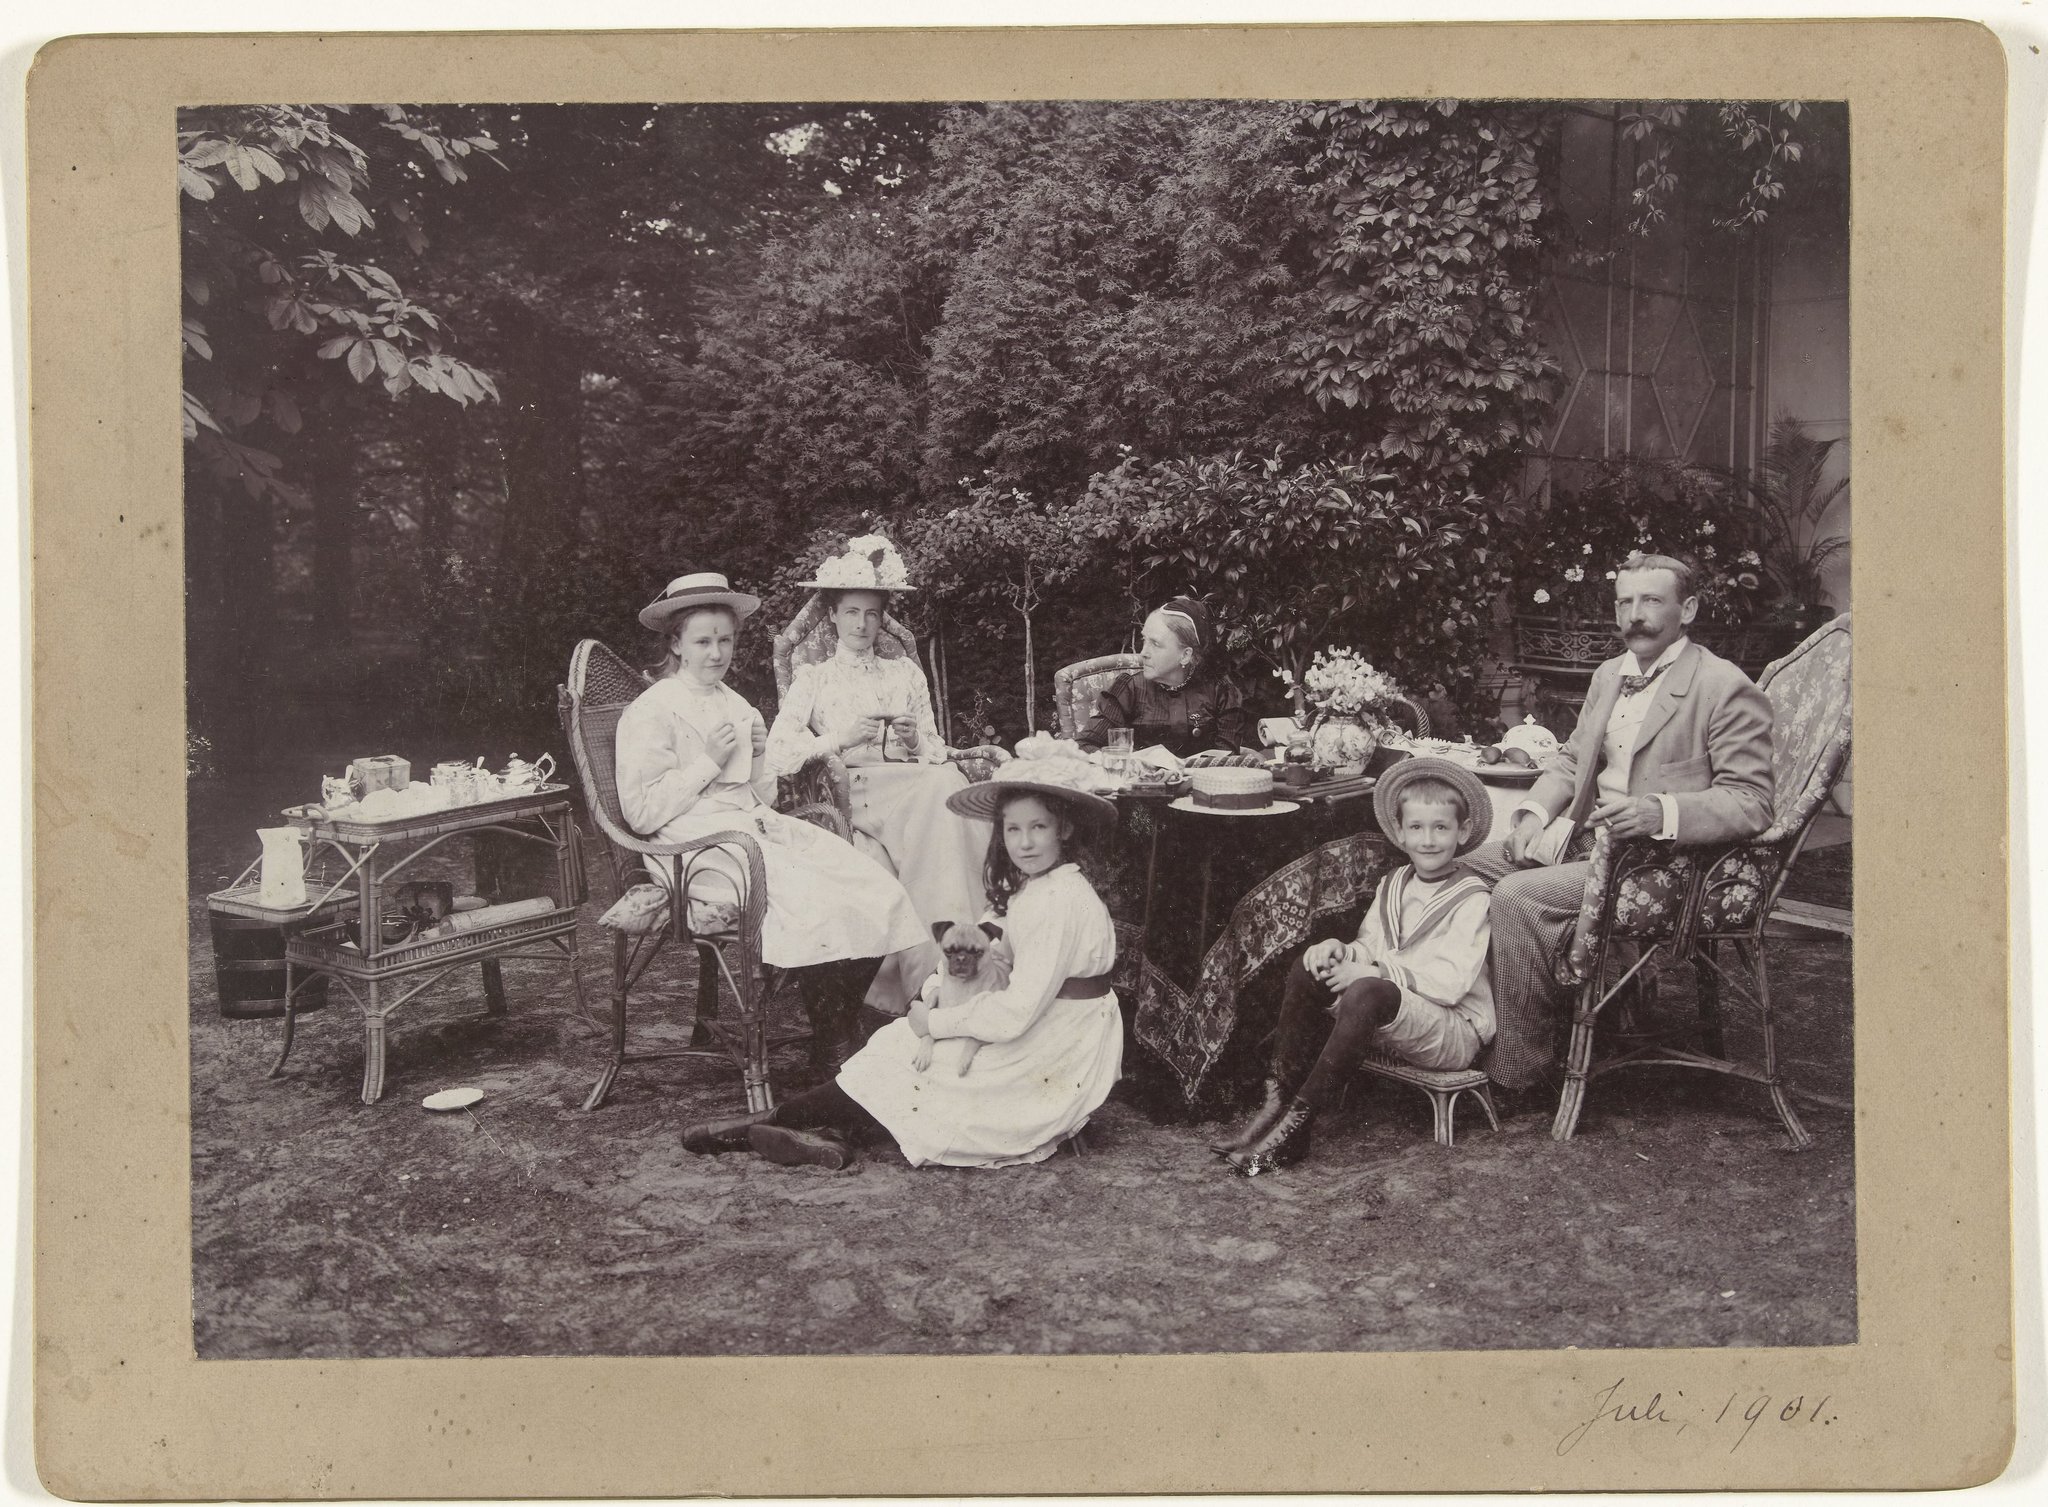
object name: photograph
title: Groepsportret van de familie Pauw van Wieldrecht aan een tafel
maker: henry pauw van wieldrecht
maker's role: fotograaf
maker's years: 1863-1912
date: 1901-1907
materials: cardboard, photographic support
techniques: gelatin silver print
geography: netherlands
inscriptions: date: ‘Juli, 1901.’, annotation: ‘Granny (Pauw) / Oom Maarten / Pauw / Annie Pauw/ ? / Reinier Pauw / Christine Pauw’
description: V.l.n.r. onbekend meisje, Annie Pauw van Wieldrecht, Christina Pauw van Wieldrecht, Aletta Cornelia Anna Voombergh (de moeder van de fotograaf), Reinier Pauw van Wieldrecht, Maarten Pauw van Wieldrecht (de broer van de fotograaf).